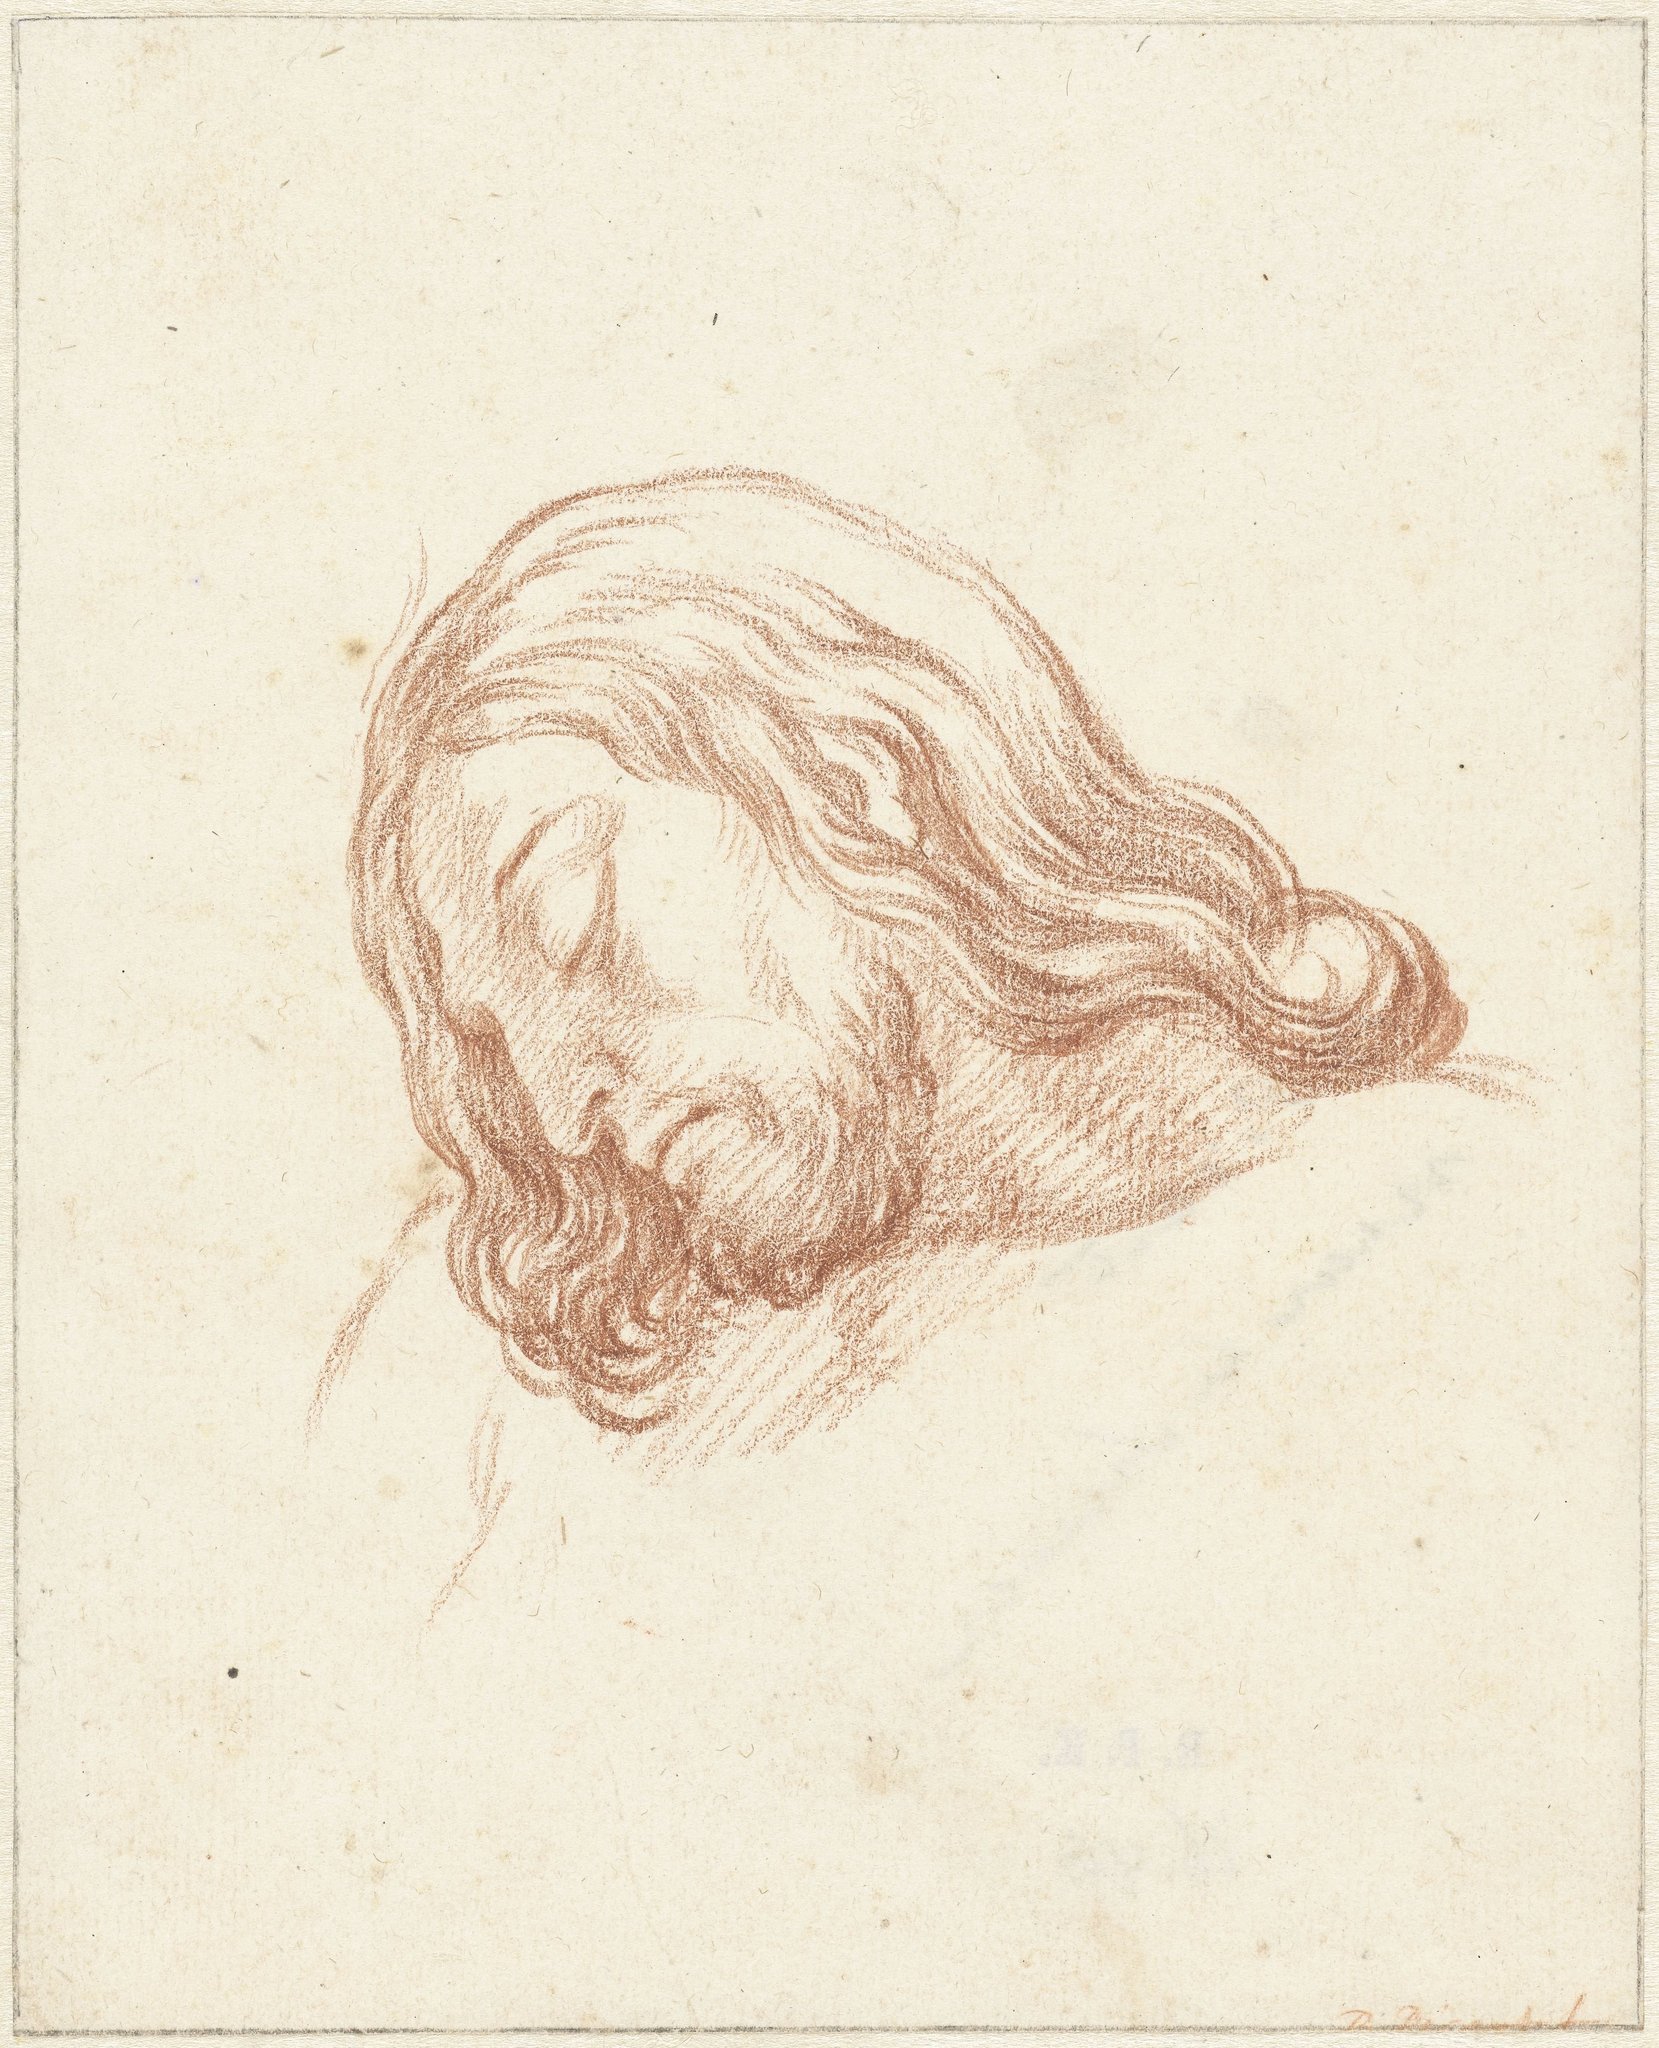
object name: drawing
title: Hoofd van Christus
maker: bernard picart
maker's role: draughtsman, print maker, publisher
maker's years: 1673-1733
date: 1683-1733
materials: chalk, paper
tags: from christ's deposition to his entombment (matthew 27:58-66; mark 15:46-47; luke 23:53-56; john 19:39-42)